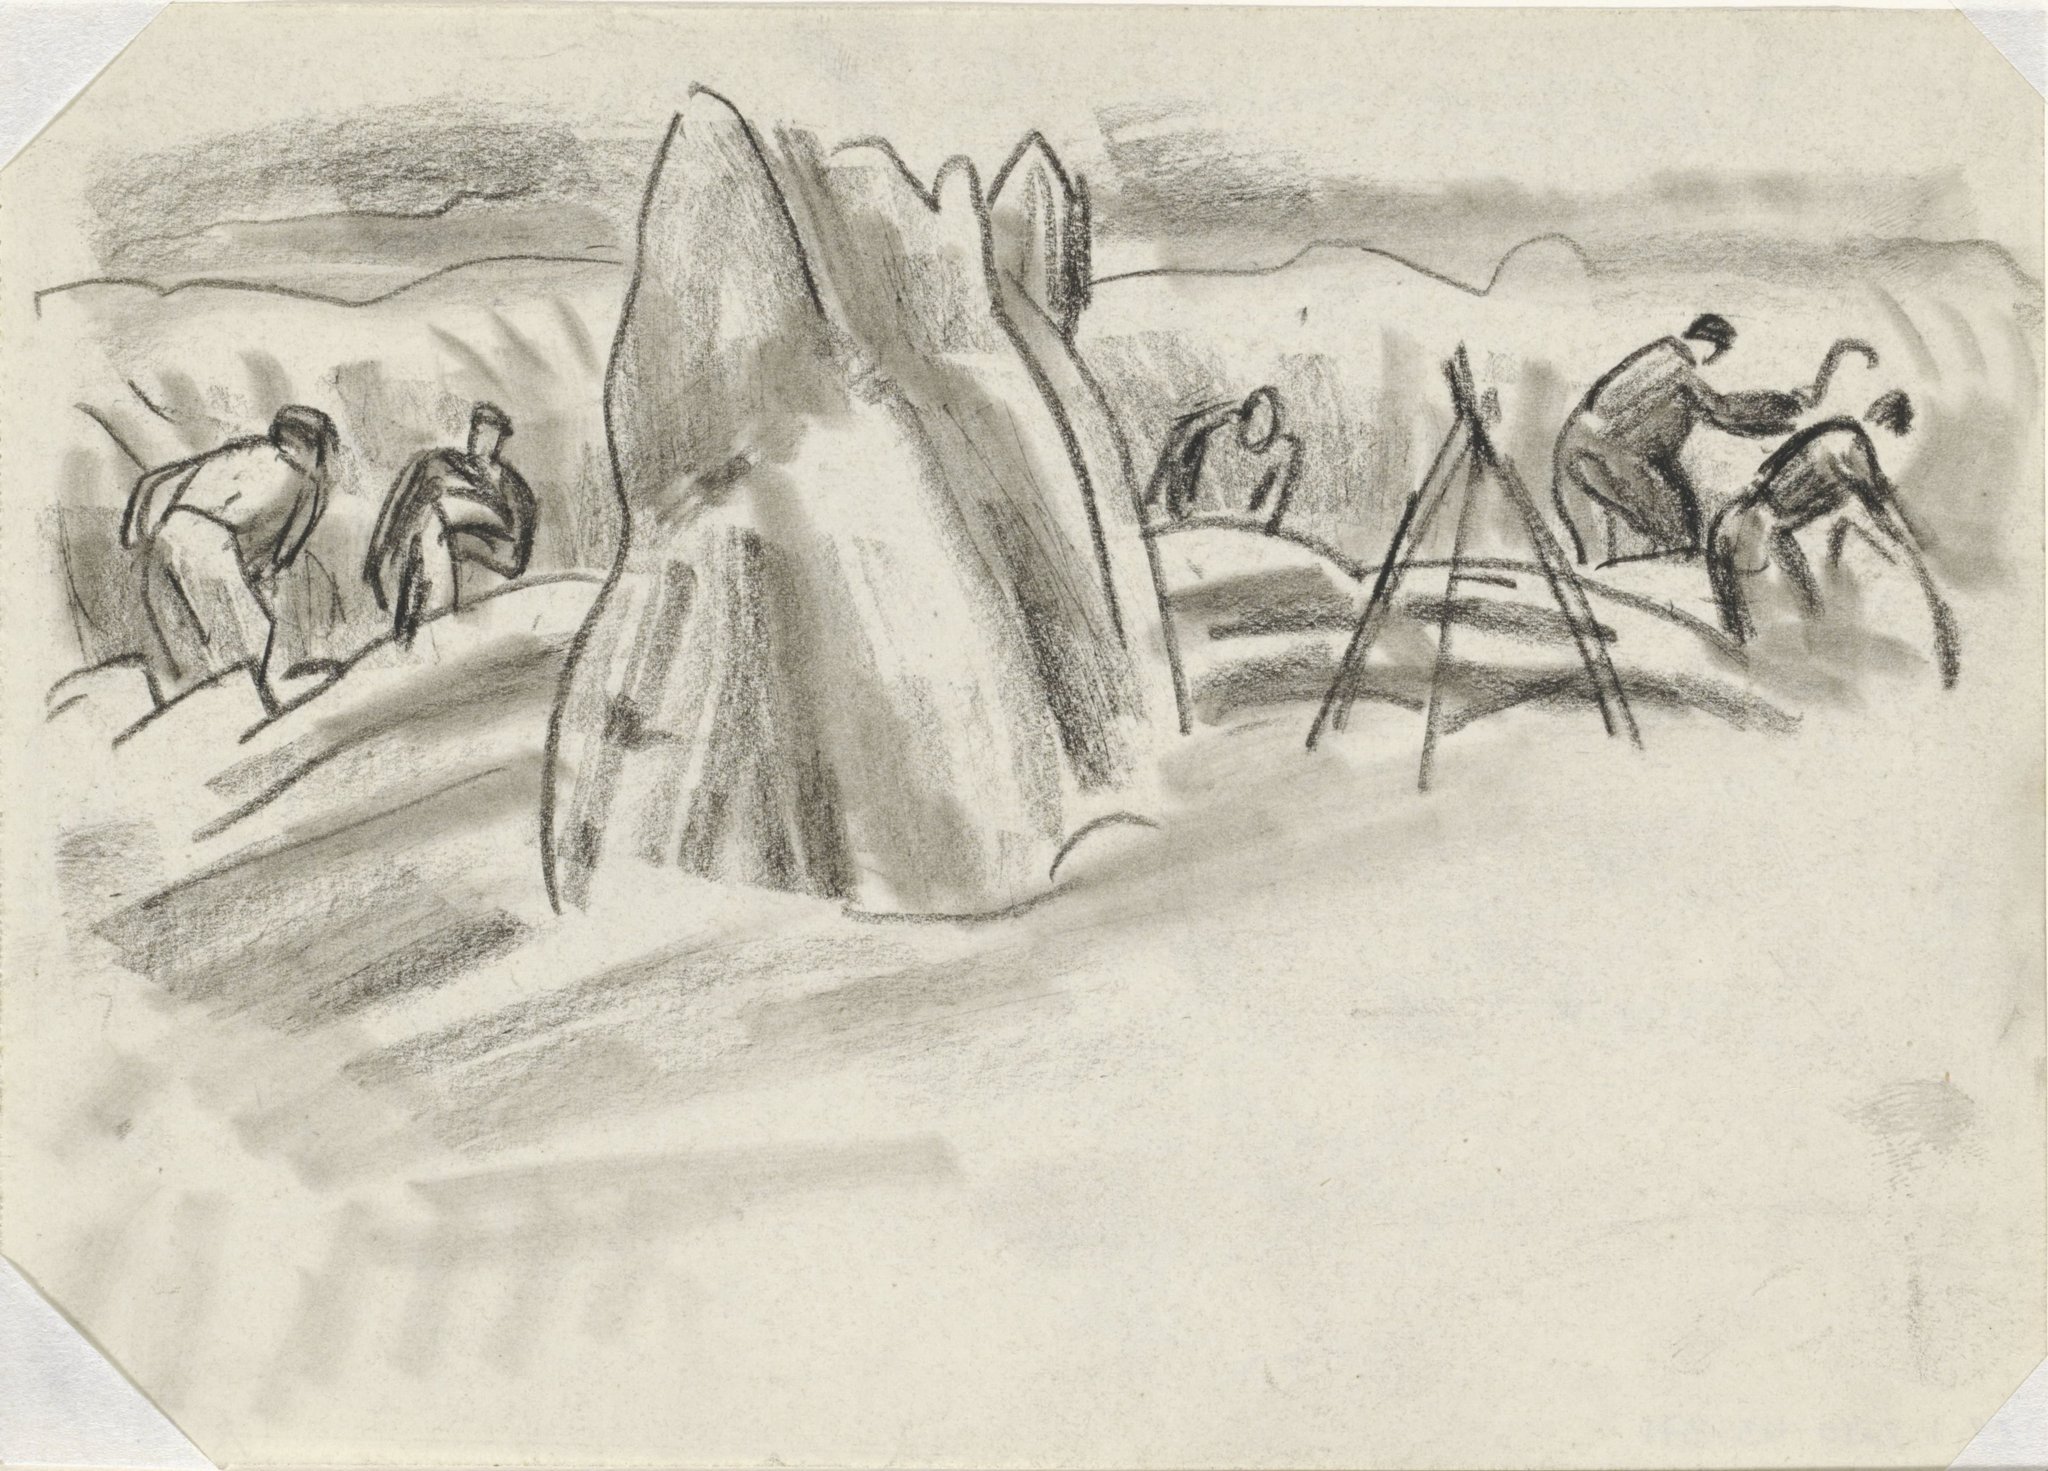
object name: drawing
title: Werkers op het land met korenschoven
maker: leo gestel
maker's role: draughtsman, print maker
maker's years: 1881-1941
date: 1925-1927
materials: chalk, paper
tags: reaping, picking, mowing ~ harvest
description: Vijf mensen zijn aan het werk op het veld, in het midden zijn een paar grote korenschoven te zien. Links houdt een man een sikkel omhoog.